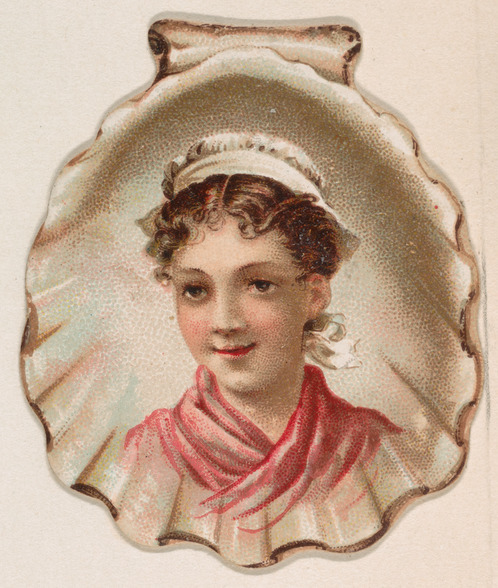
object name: print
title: Seashell, from the Novelties series (N228, Type 3) issued by Kinney Bros.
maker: kinney brothers tobacco company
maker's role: publisher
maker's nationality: american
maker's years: 1869-2011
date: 1889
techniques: color lithograph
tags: women,shells